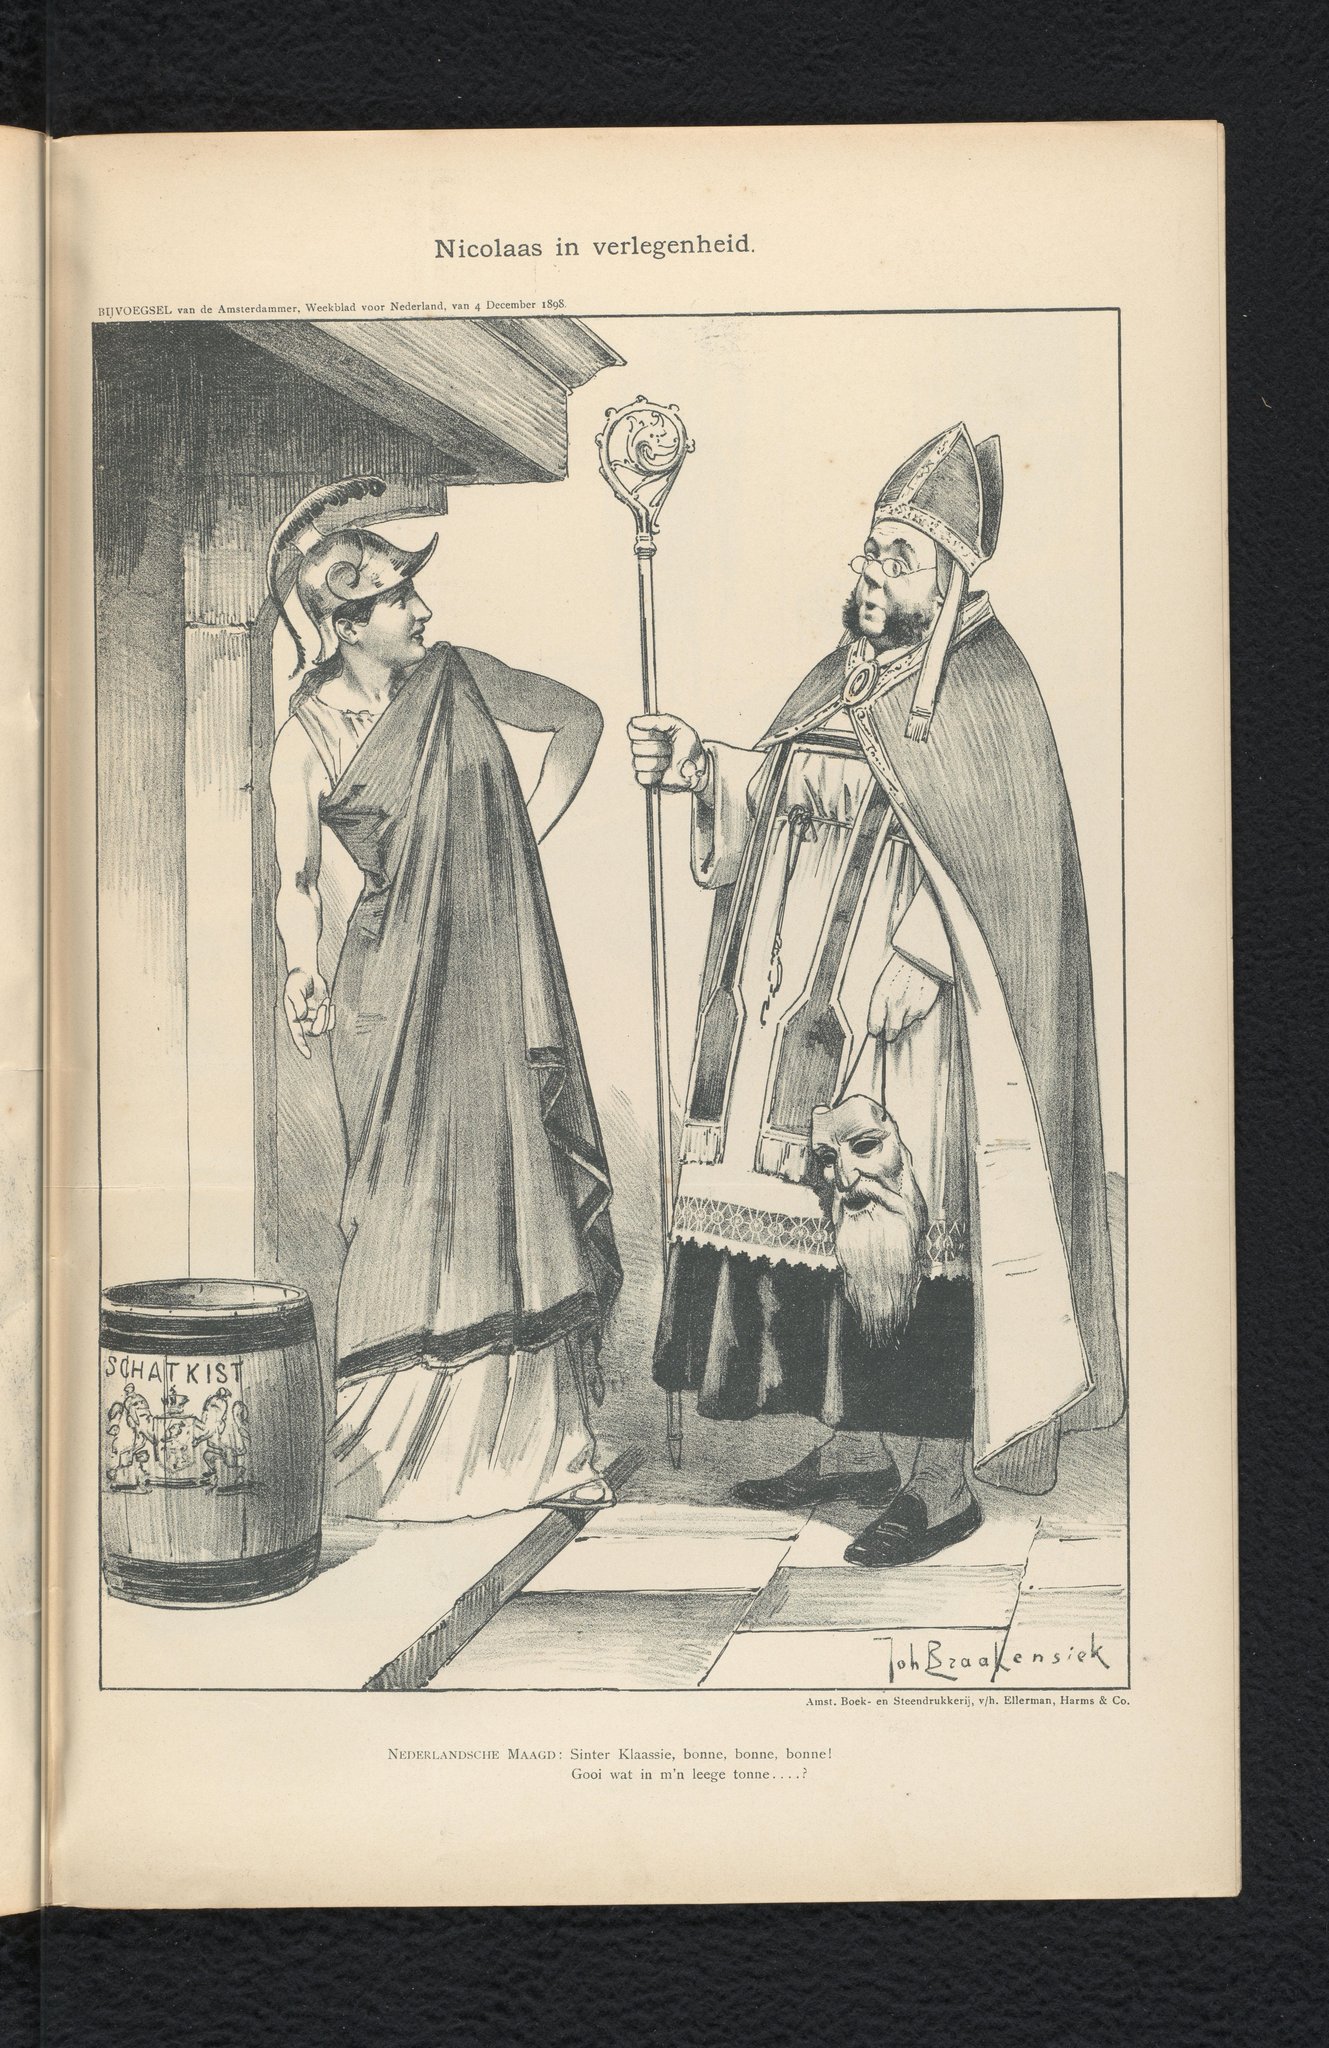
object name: cartoon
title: Nicolaas in verlegenheid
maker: johan braakensiek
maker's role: draughtsman, print maker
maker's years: 1858-1940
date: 1898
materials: paper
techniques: lithograph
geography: amsterdam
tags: amsterdam, politician, nicolaas gerard pierson, mask, wooden container: barrel, cask, bucket, personifications of countries, nations, states, districts, etc., festivities on st. nicholas (eve) (december 5), political caricatures and satires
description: De Nederlandse Maagd vraagt aan Sint Nicolaas (premier Pierson) om de schatkist aan te vullen.